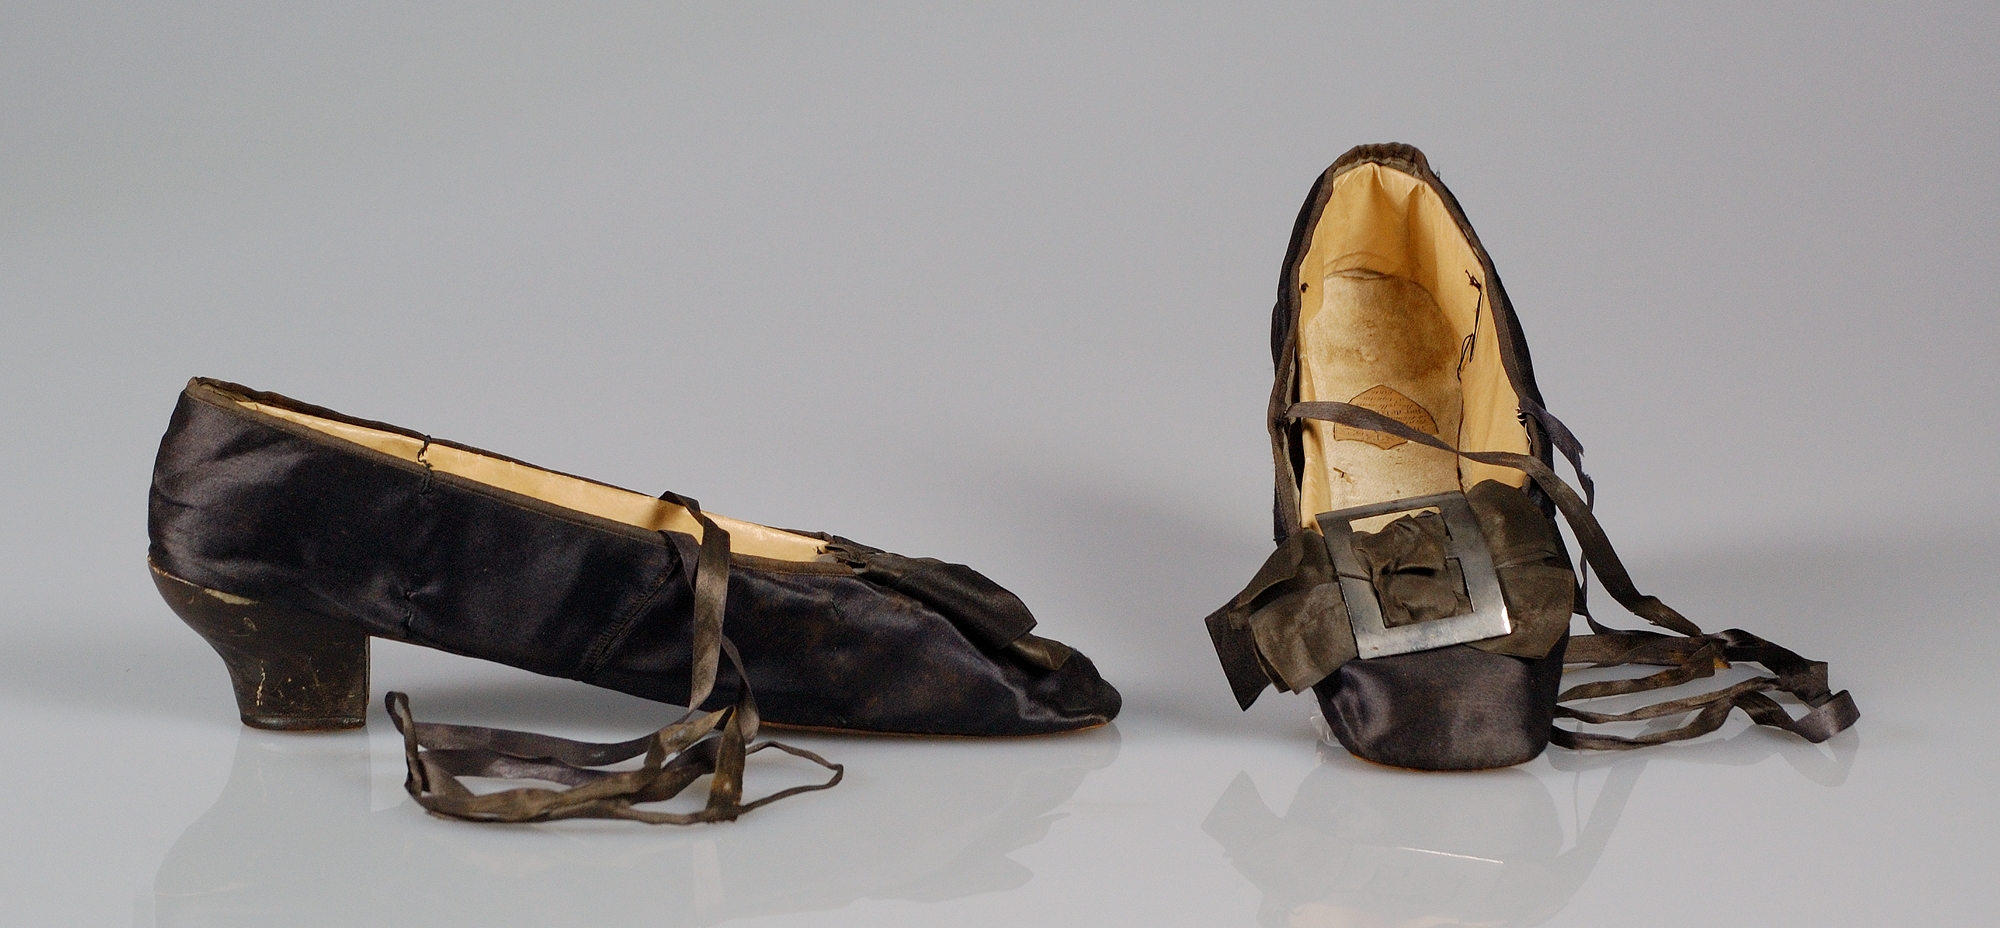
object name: evening slipper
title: Evening slippers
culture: french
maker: esté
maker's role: maker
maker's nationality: french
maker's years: 1821-1839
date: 1860-1869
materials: metal, silk